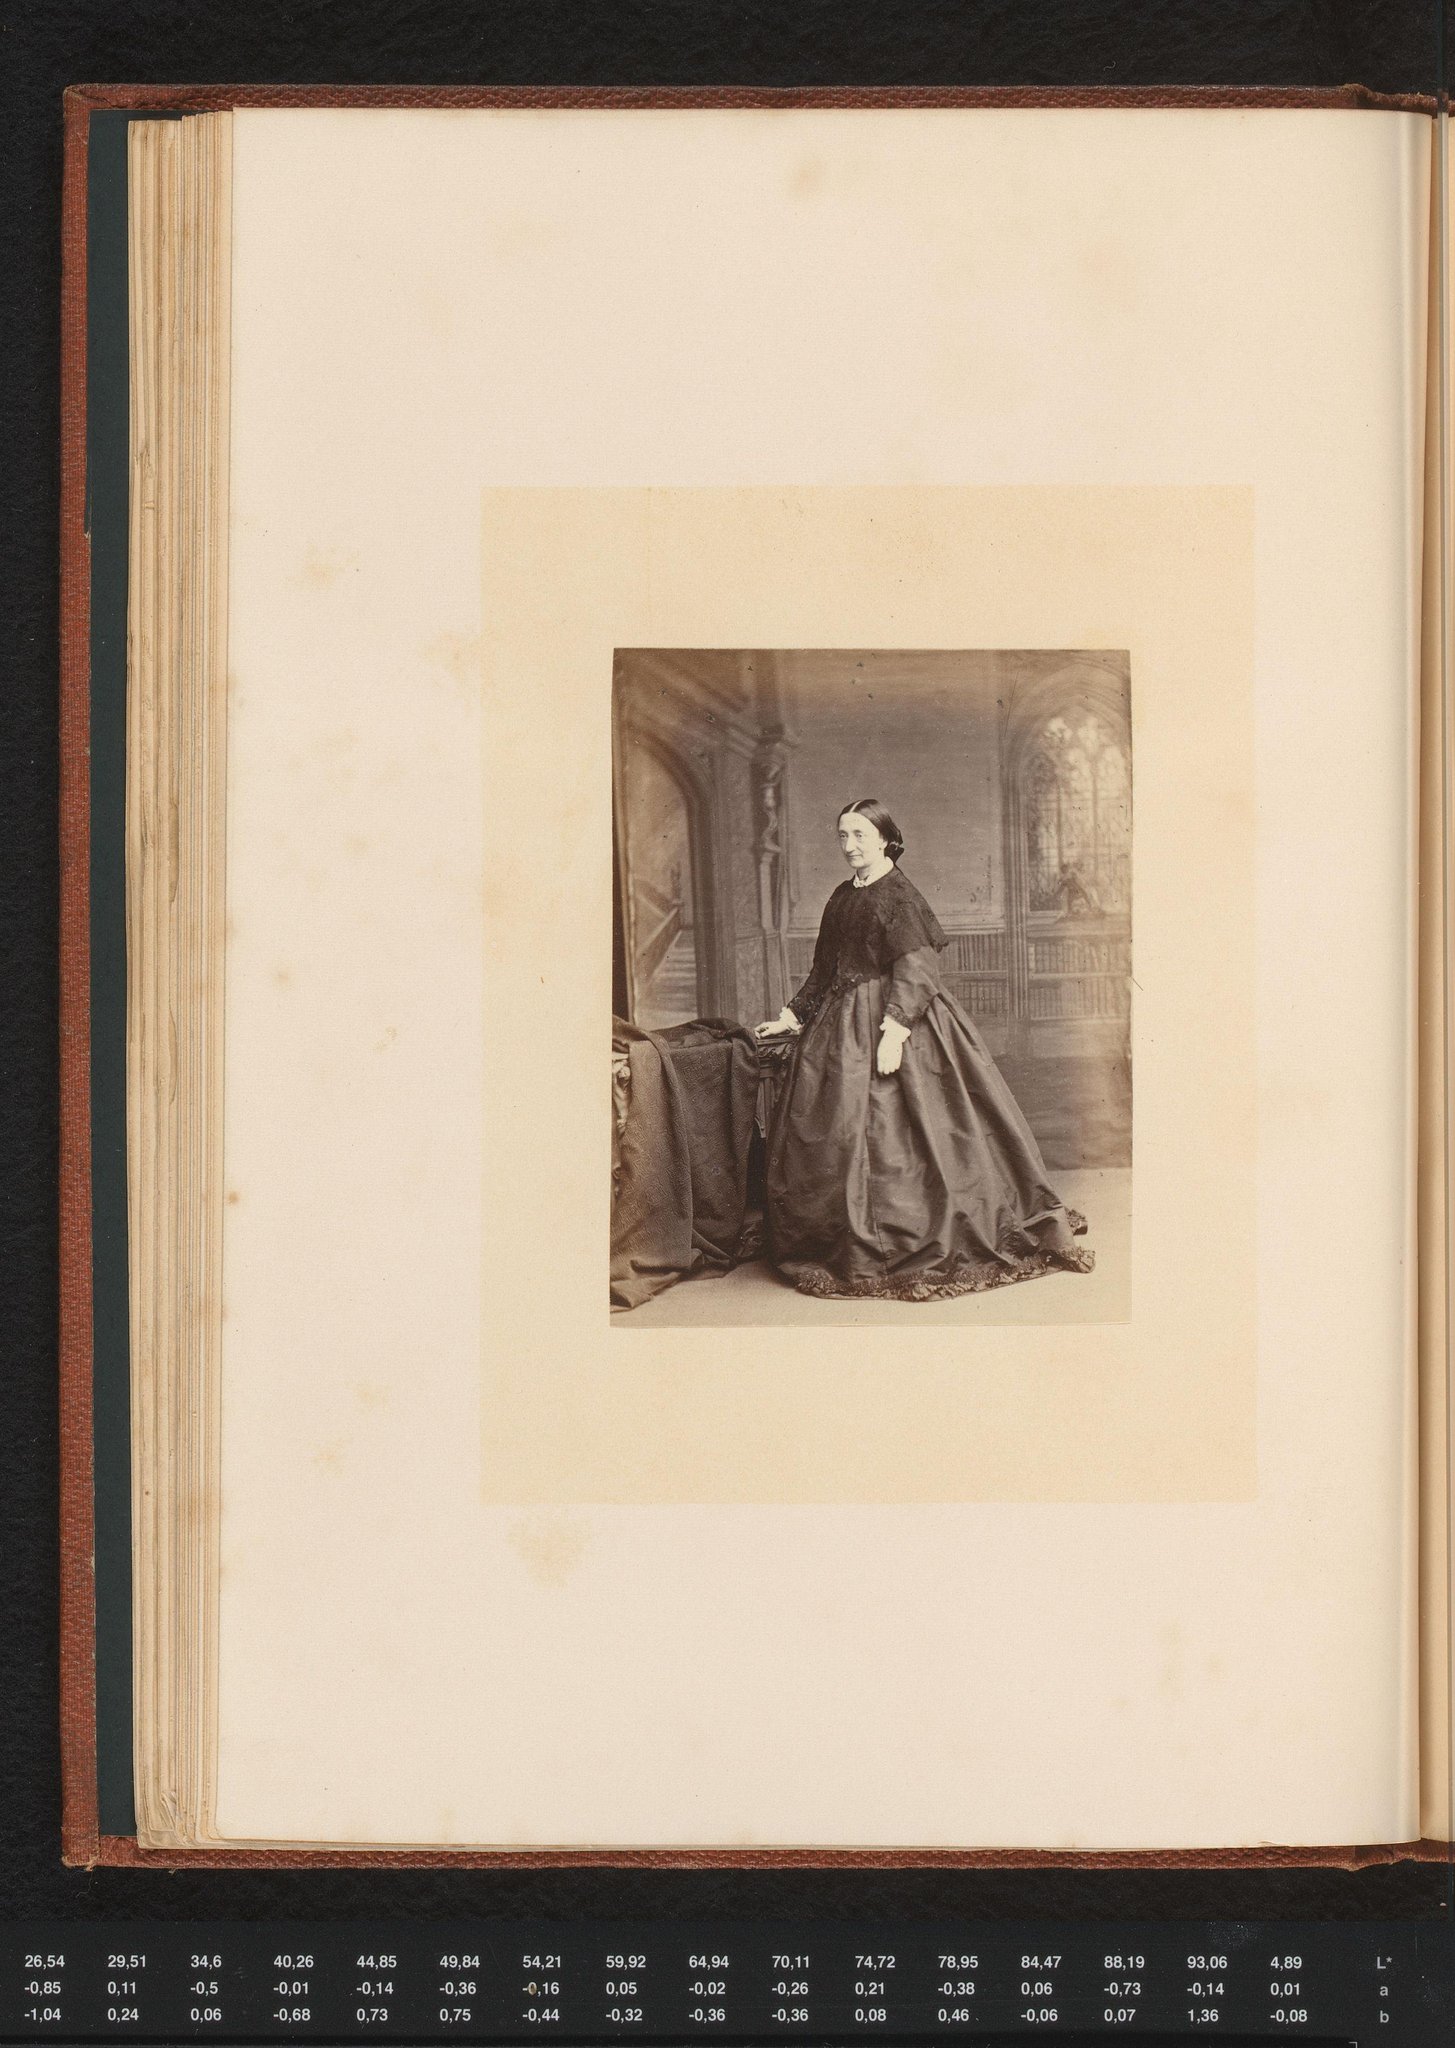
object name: page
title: Portret van de schrijfster Eliza Meteyard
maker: ernest edwards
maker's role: fotograaf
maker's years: 1837-1903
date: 1861-1866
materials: paper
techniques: albumen print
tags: eliza meteyard, portrait of a writer